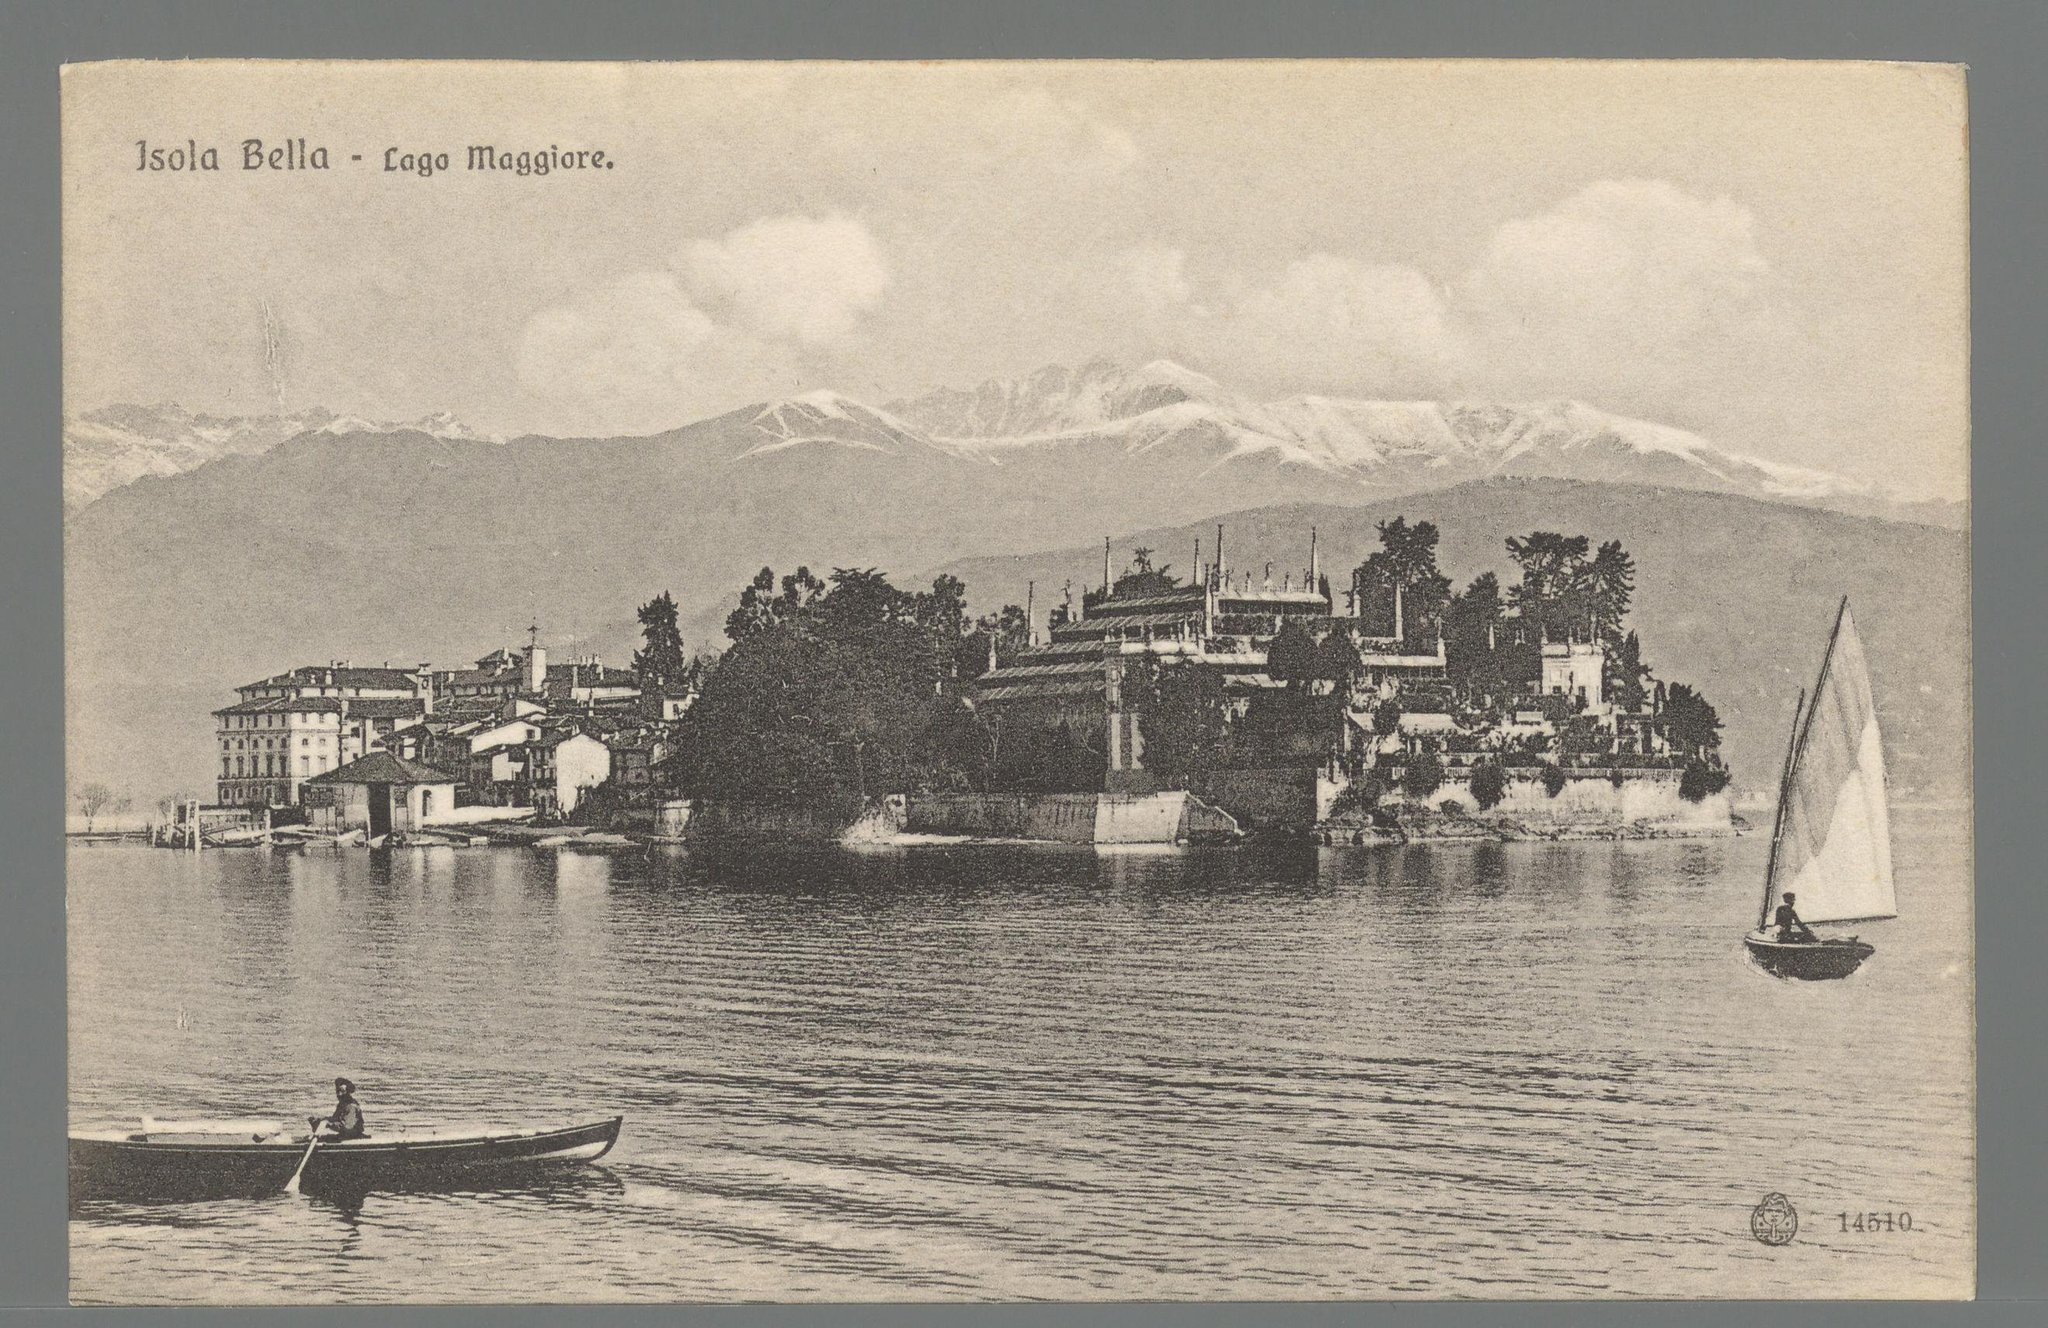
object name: photomechanical print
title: Isola Bella. Lago Maggiore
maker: Anonymous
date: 1905-1909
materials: cardboard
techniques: photograph, writing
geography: zurich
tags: prospect of village, silhouette of village, lake, mountains